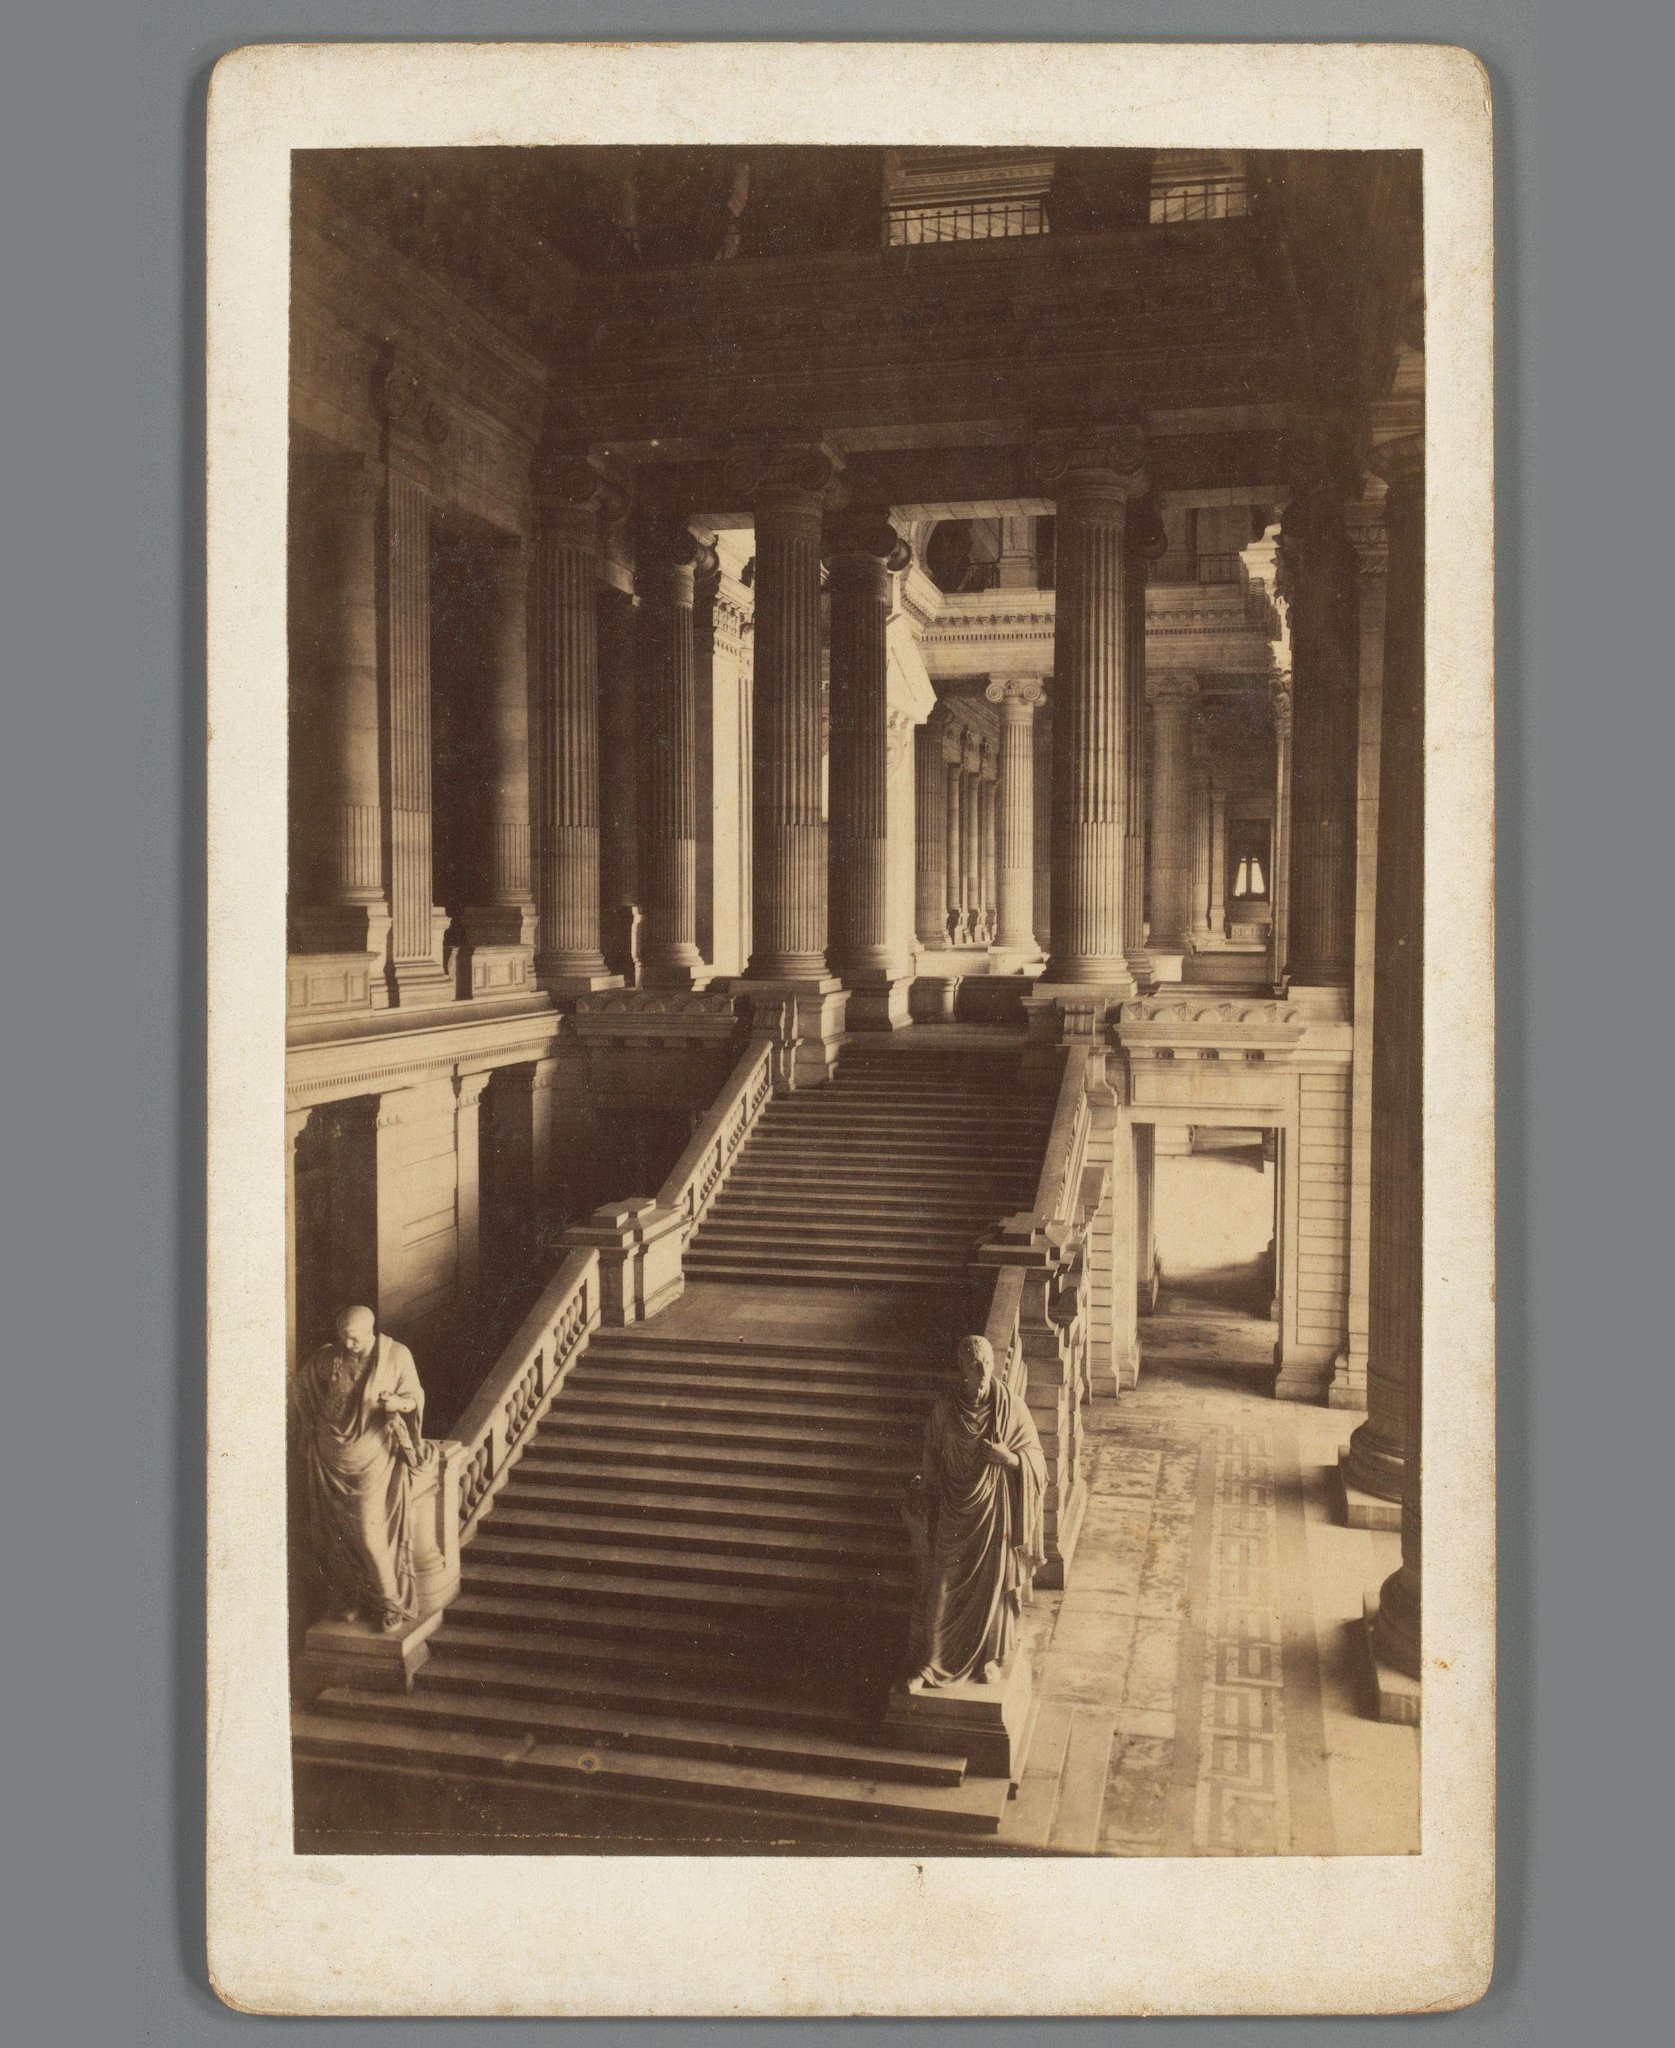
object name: cabinet photograph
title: Bruxelles. Palais de Justice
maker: Anonymous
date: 1883-1890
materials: cardboard, paper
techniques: albumen print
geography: brussels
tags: court building, staircase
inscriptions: collector's mark: ‘Vosmaer’